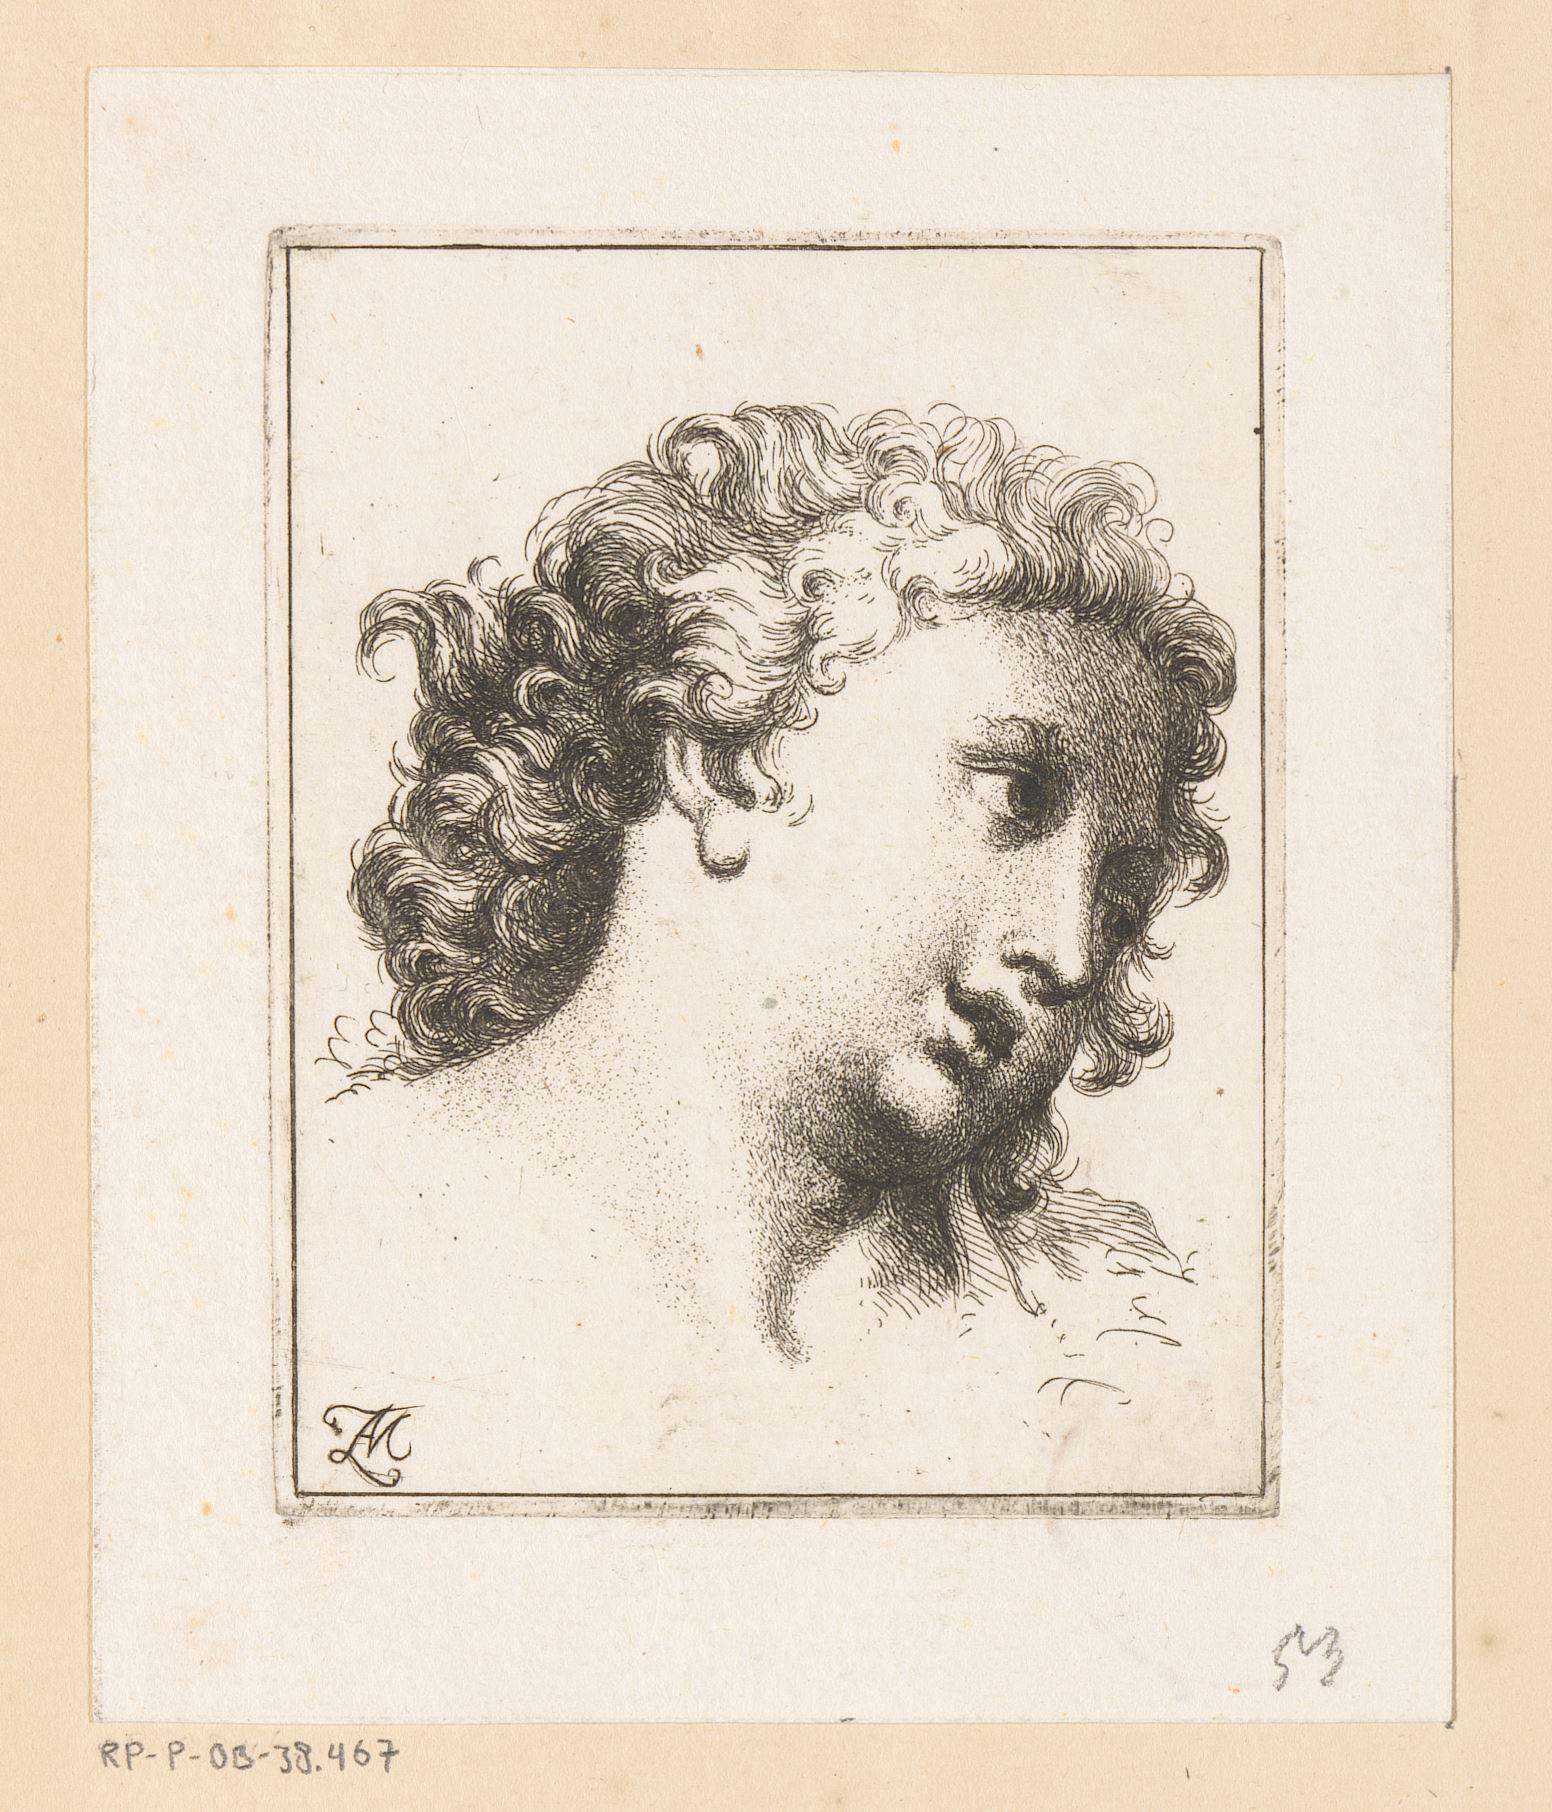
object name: print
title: Hoofd van een vrouw met losse haren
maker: anton maria i zanetti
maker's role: draughtsman, painter, print maker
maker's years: 1680-1757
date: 1690-1757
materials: paper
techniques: etching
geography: italy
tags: adolescent, young woman, maiden, head (human)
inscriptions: collector's mark: Lugt 240